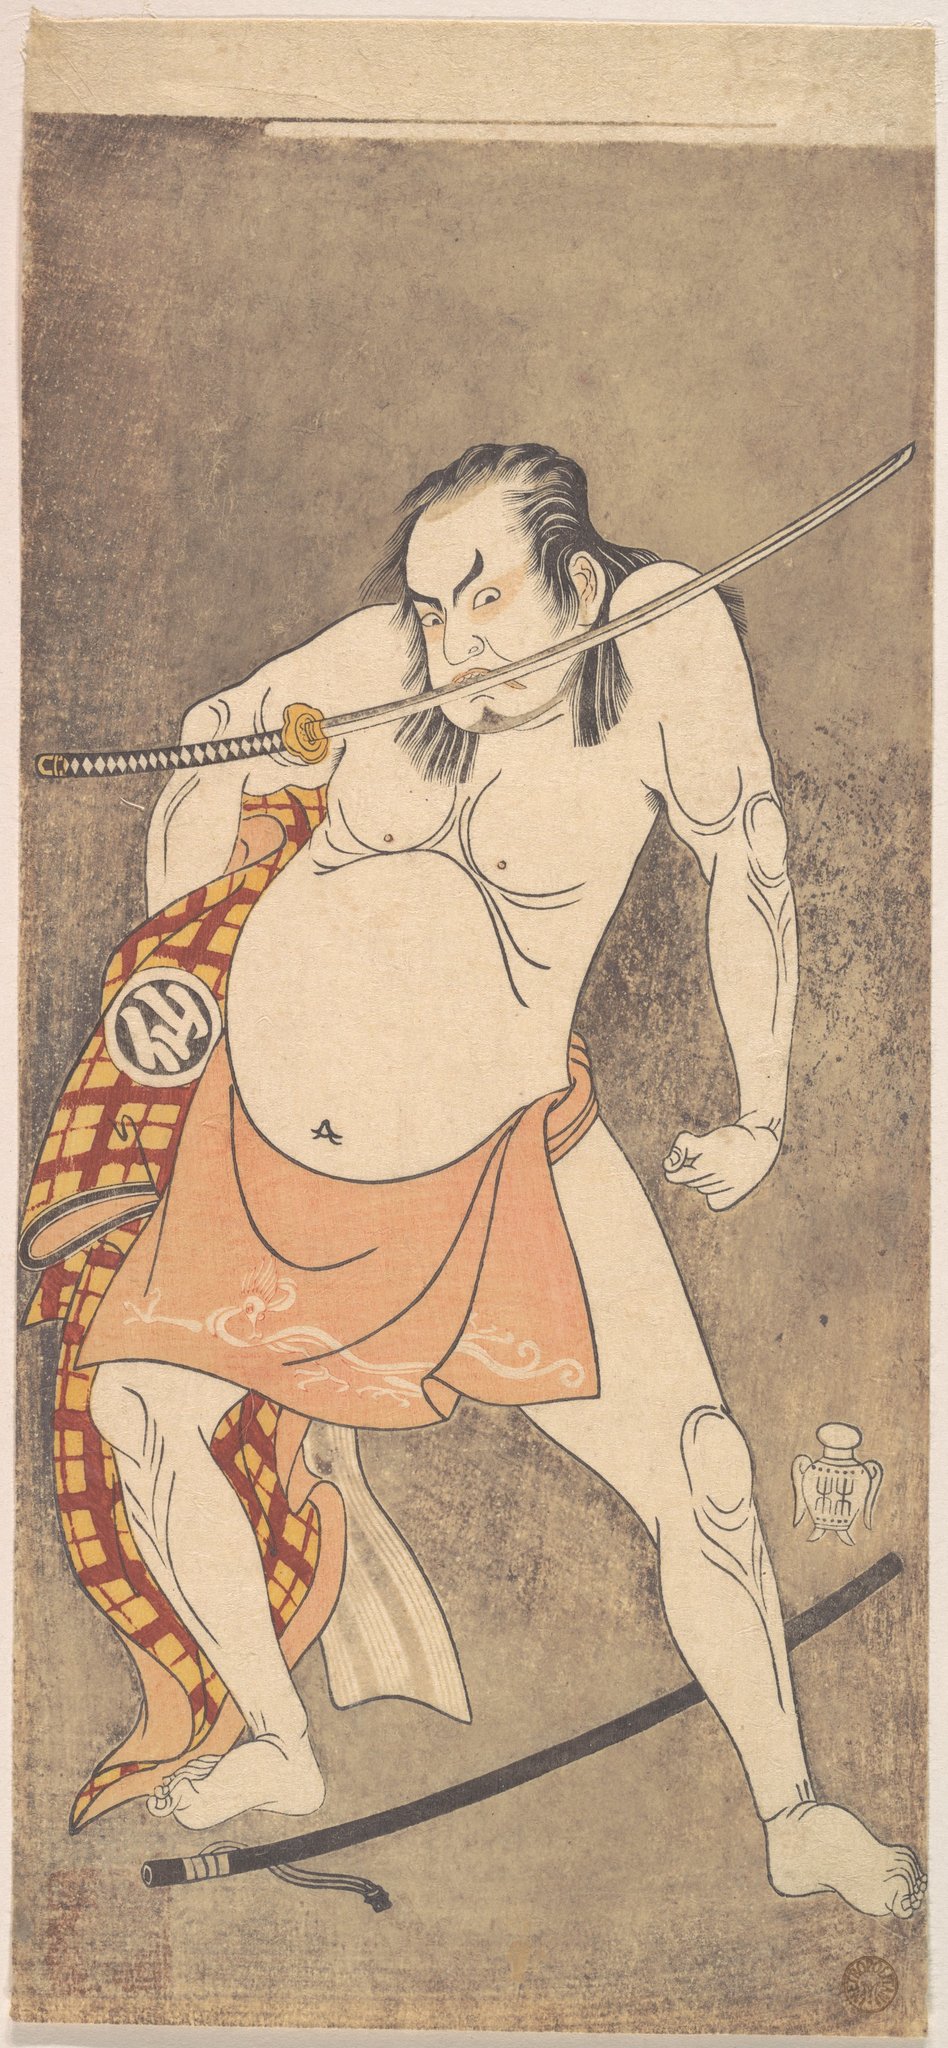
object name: woodblock print nishiki e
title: The Second Nakamura Sukegoro as a Man Entirely Nude Save for Loin Cloth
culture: japanese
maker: katsukawa shunshō 勝川春章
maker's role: artist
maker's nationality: japanese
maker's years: 1726-1792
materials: ink, paper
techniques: nishiki e, woodblock print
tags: swords,men,actors